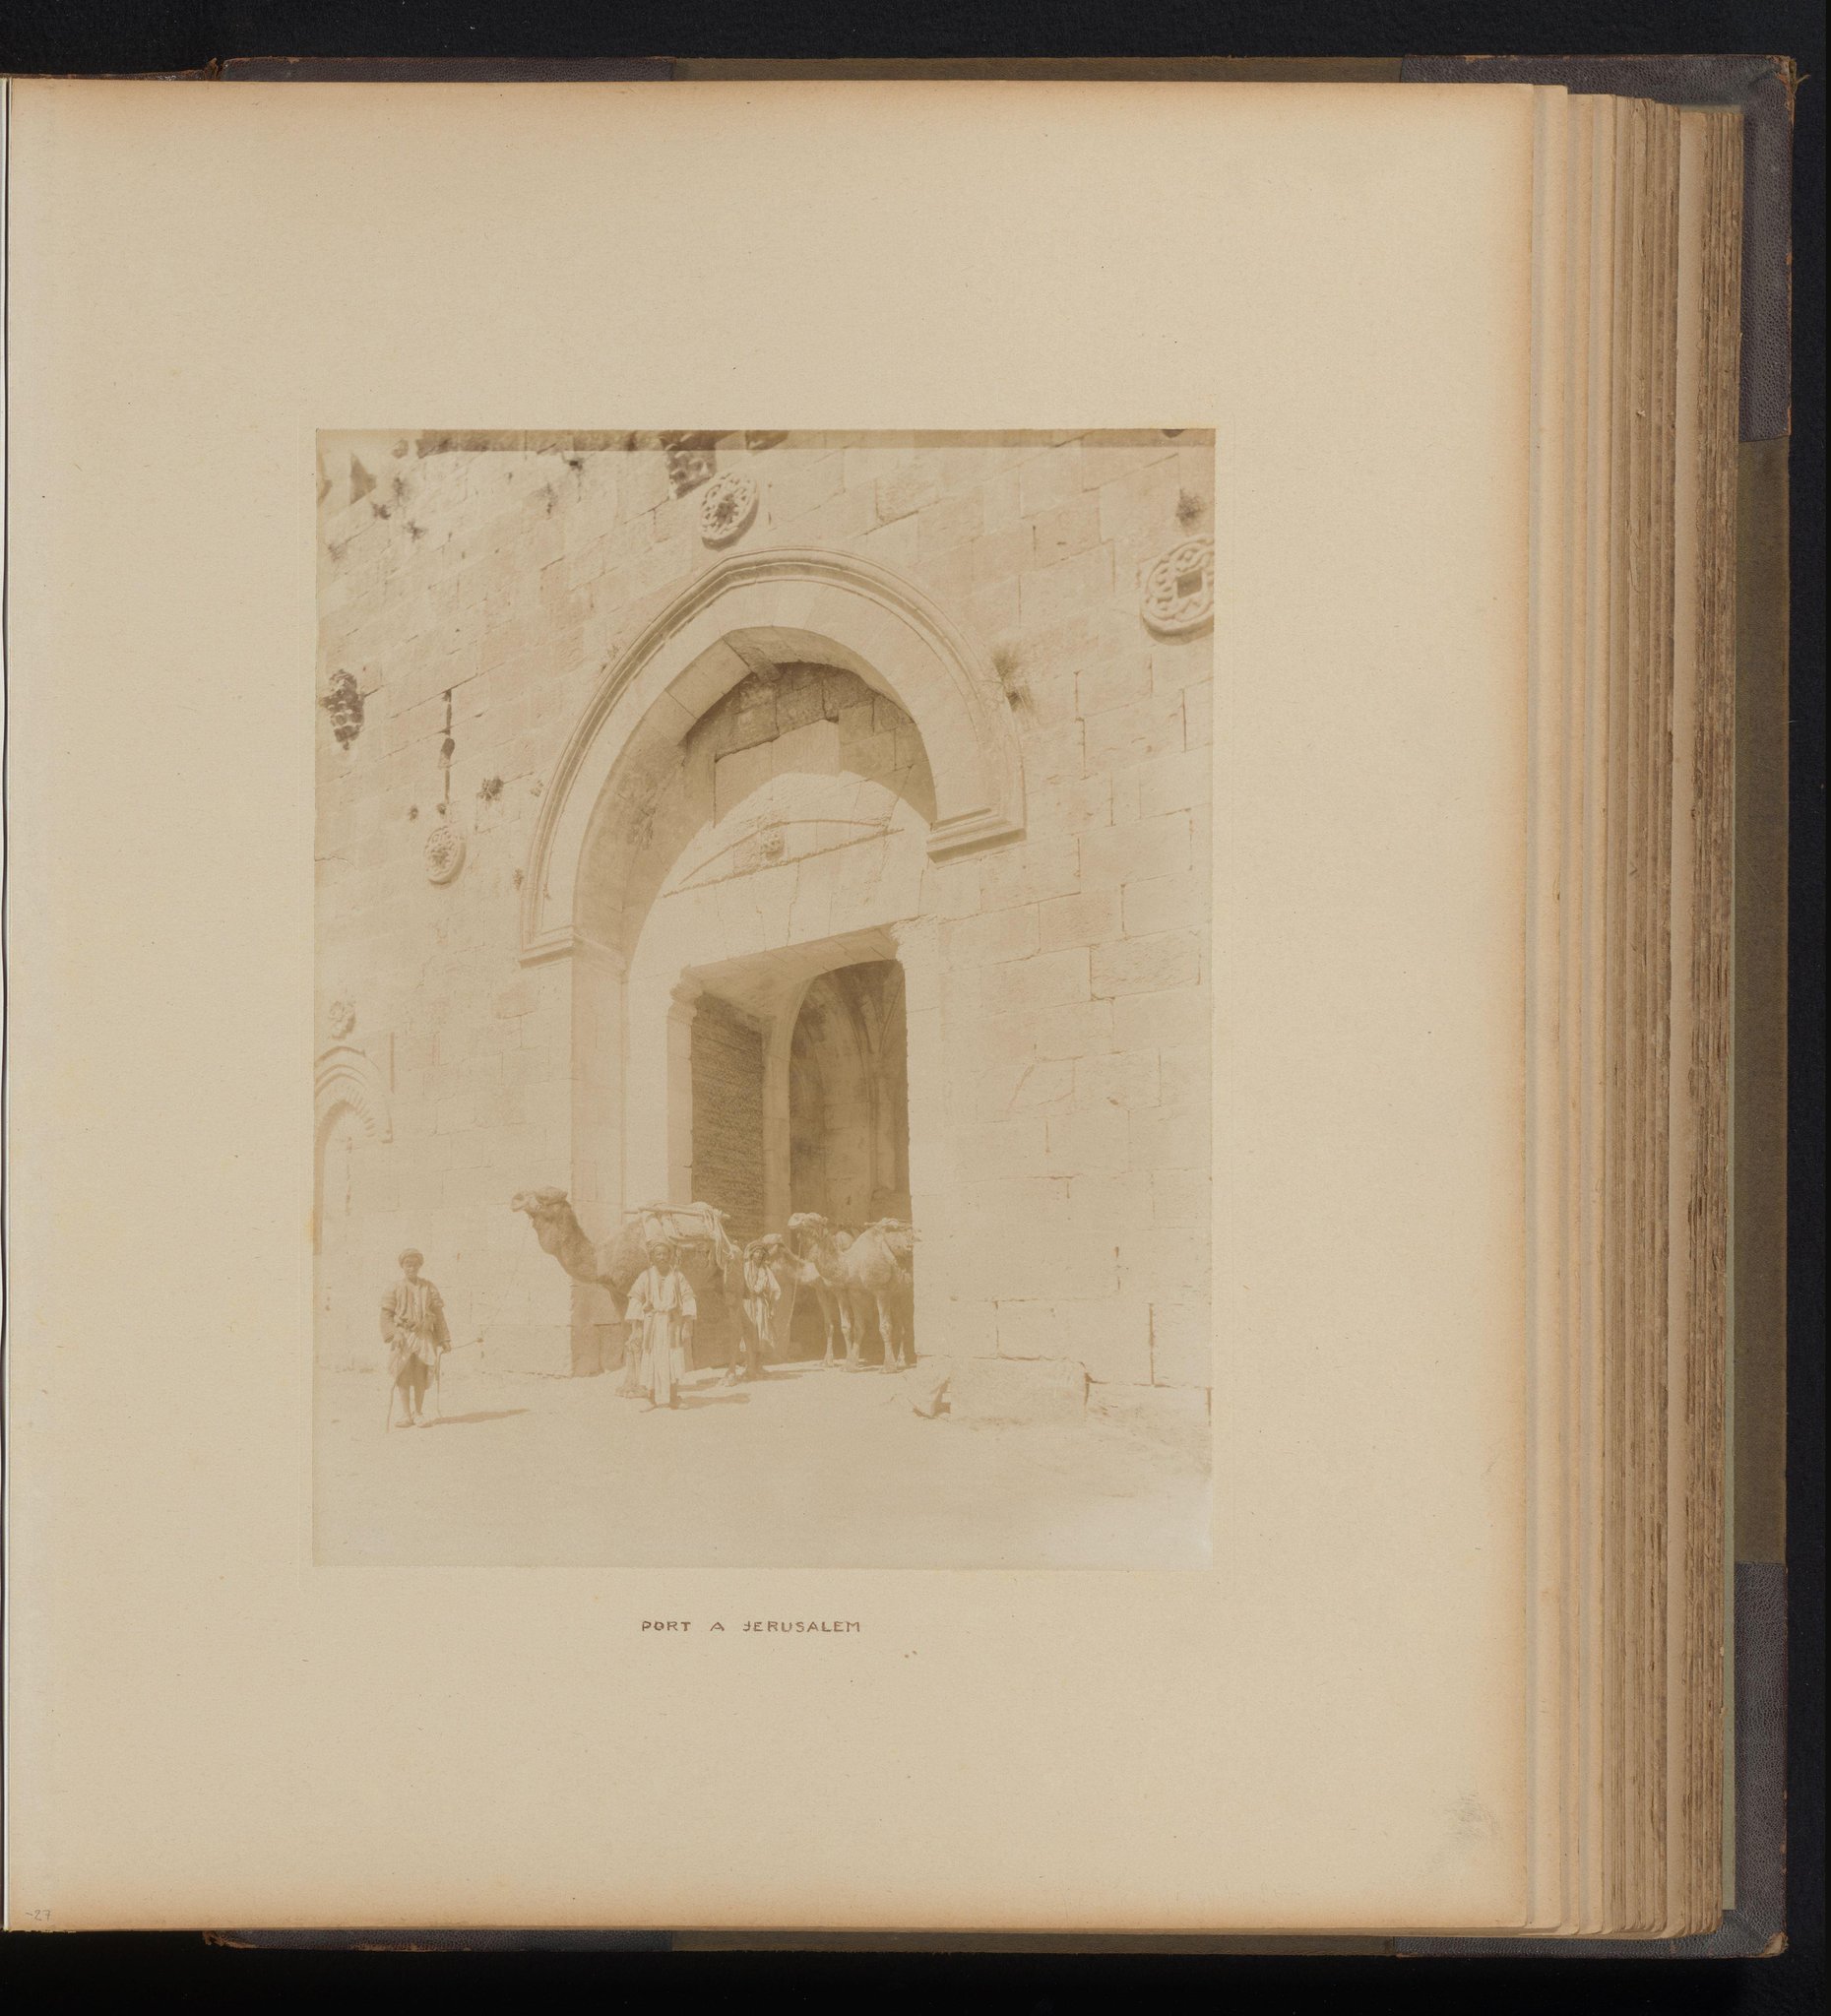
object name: photograph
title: Port a Jerusalem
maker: Anonymous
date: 1851-1910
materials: paper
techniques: albumen print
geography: jerusalem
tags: gate, entrance